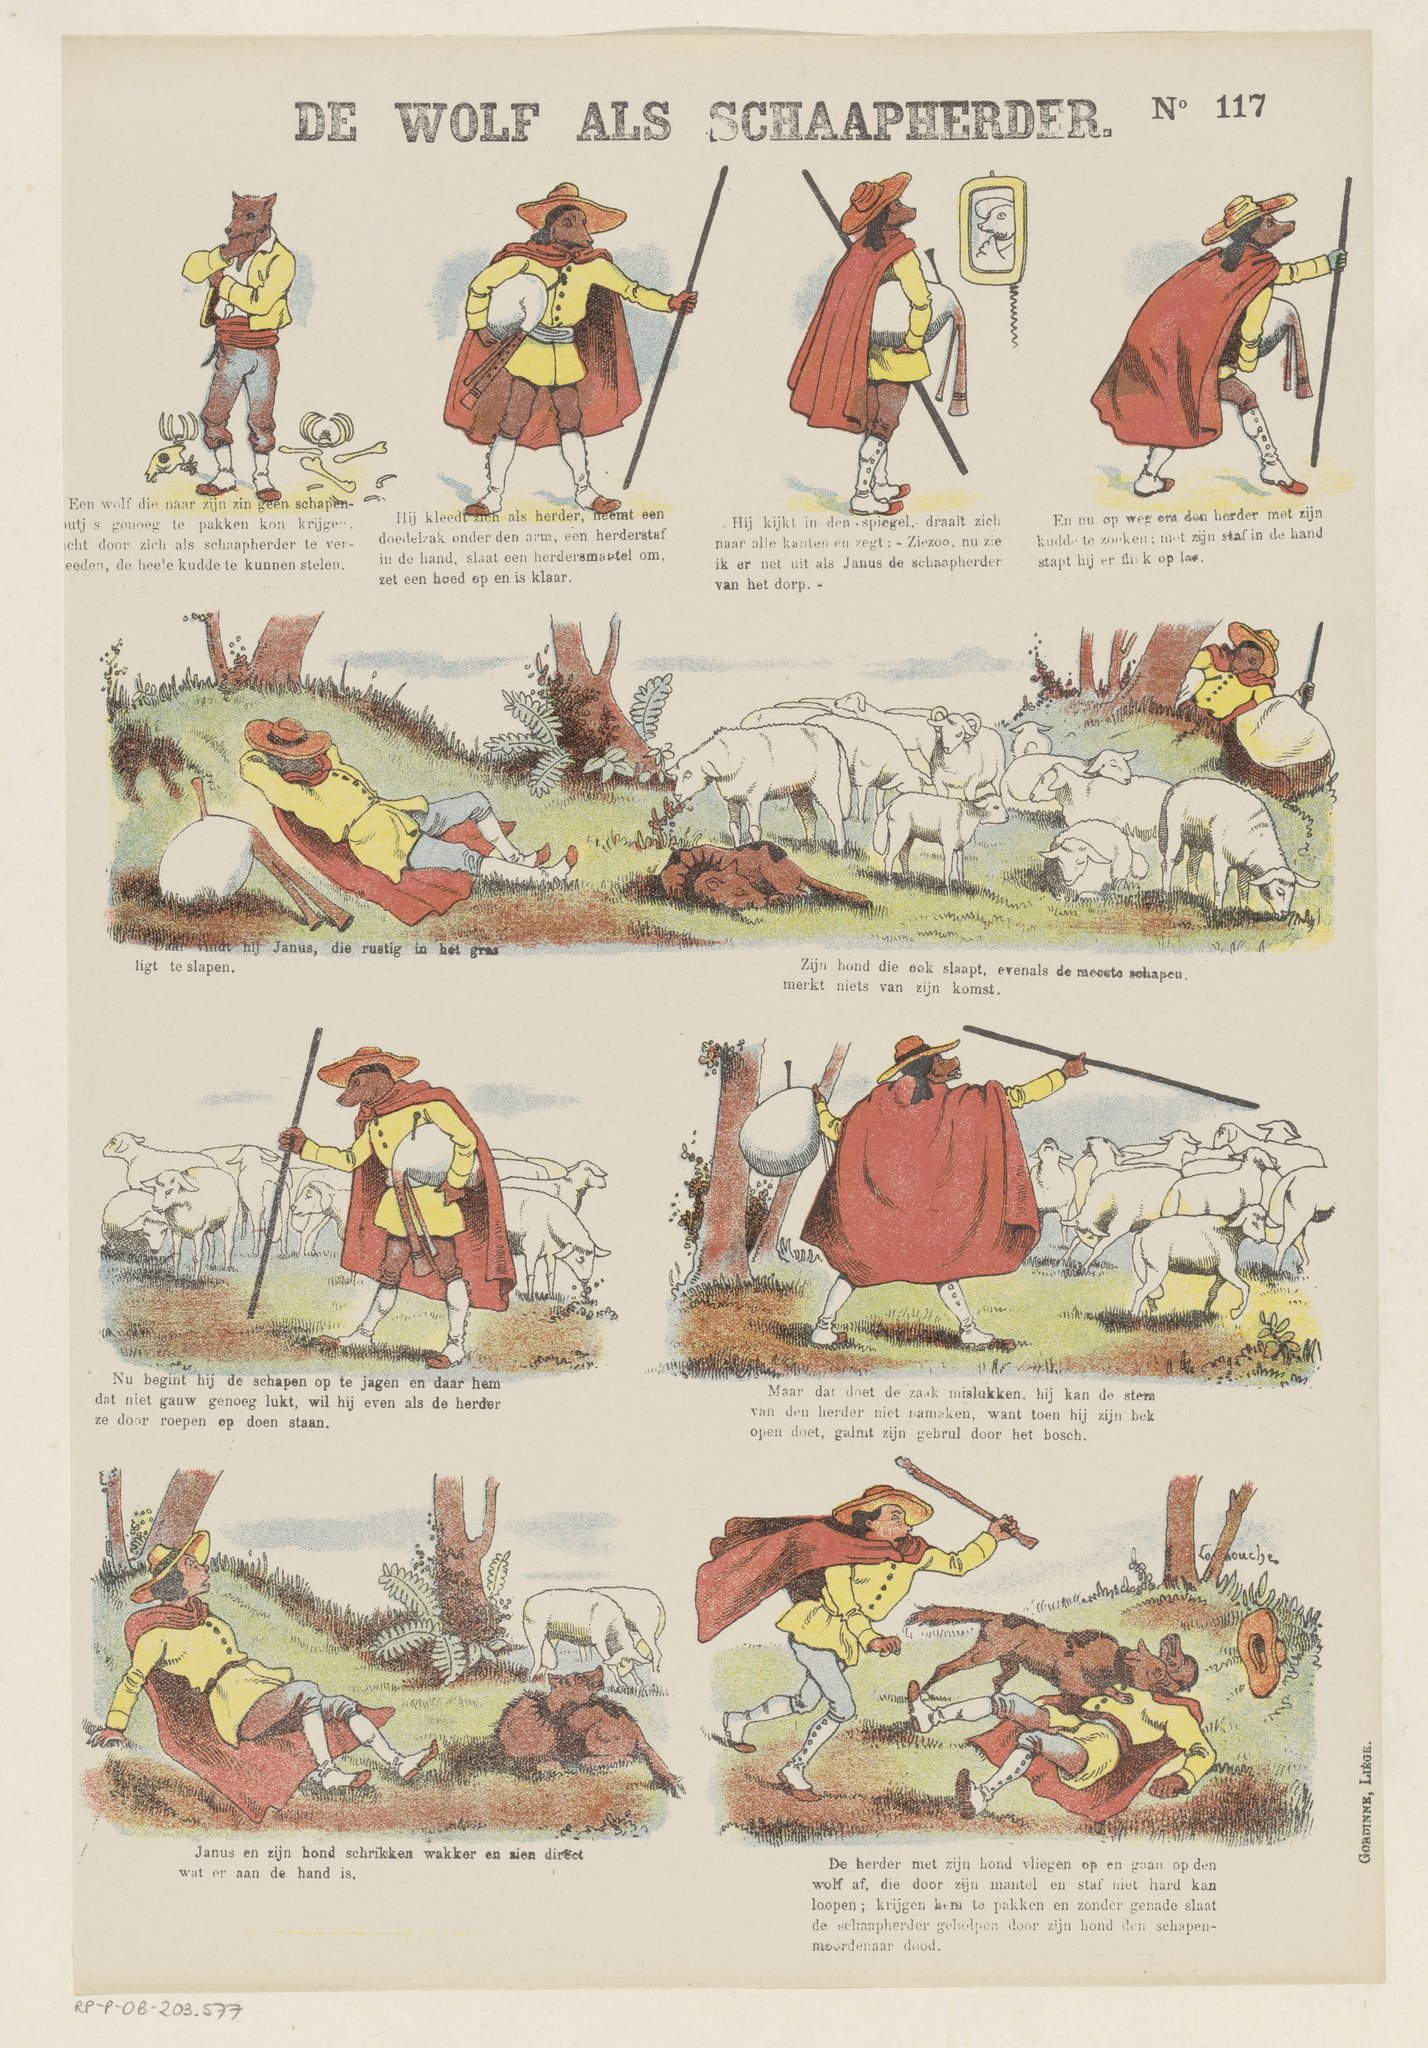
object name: print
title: De wolf als schaapherder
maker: Anonymous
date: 1894-1959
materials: paper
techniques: lithograph, letterpress printing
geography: liège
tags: herding, herdsman, herdswoman, shepherd, shepherdess, cowherd, etc., animals acting as human beings, sheep, beasts of prey, predatory animals: wolf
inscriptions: collector's mark: Lugt 2760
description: Blad met 9 voorstellingen over een wolf die zich voordoet als een schaapherder. Onder elke afbeelding een onderschrift. Genummerd rechtsboven: No 117.